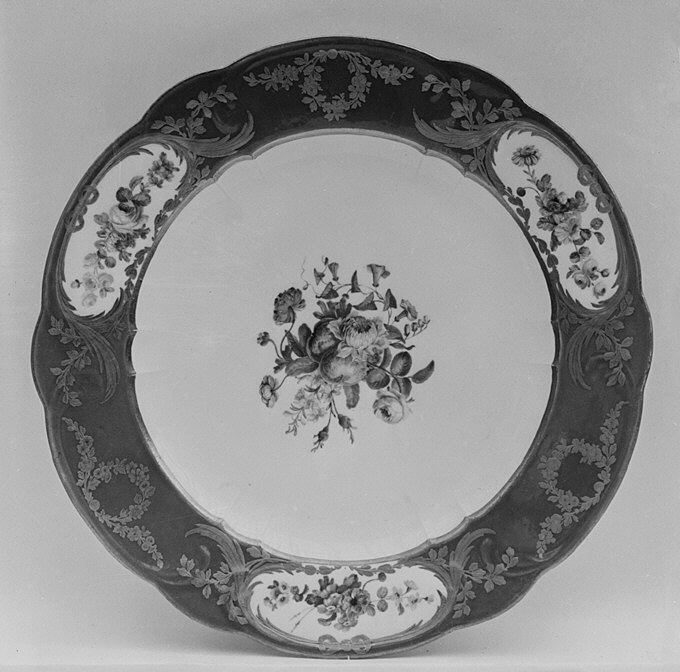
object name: plate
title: Plate (part of a service)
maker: sèvres manufactory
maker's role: manufactory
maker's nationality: french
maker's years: 1740-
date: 1784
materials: soft paste porcelain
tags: flowers